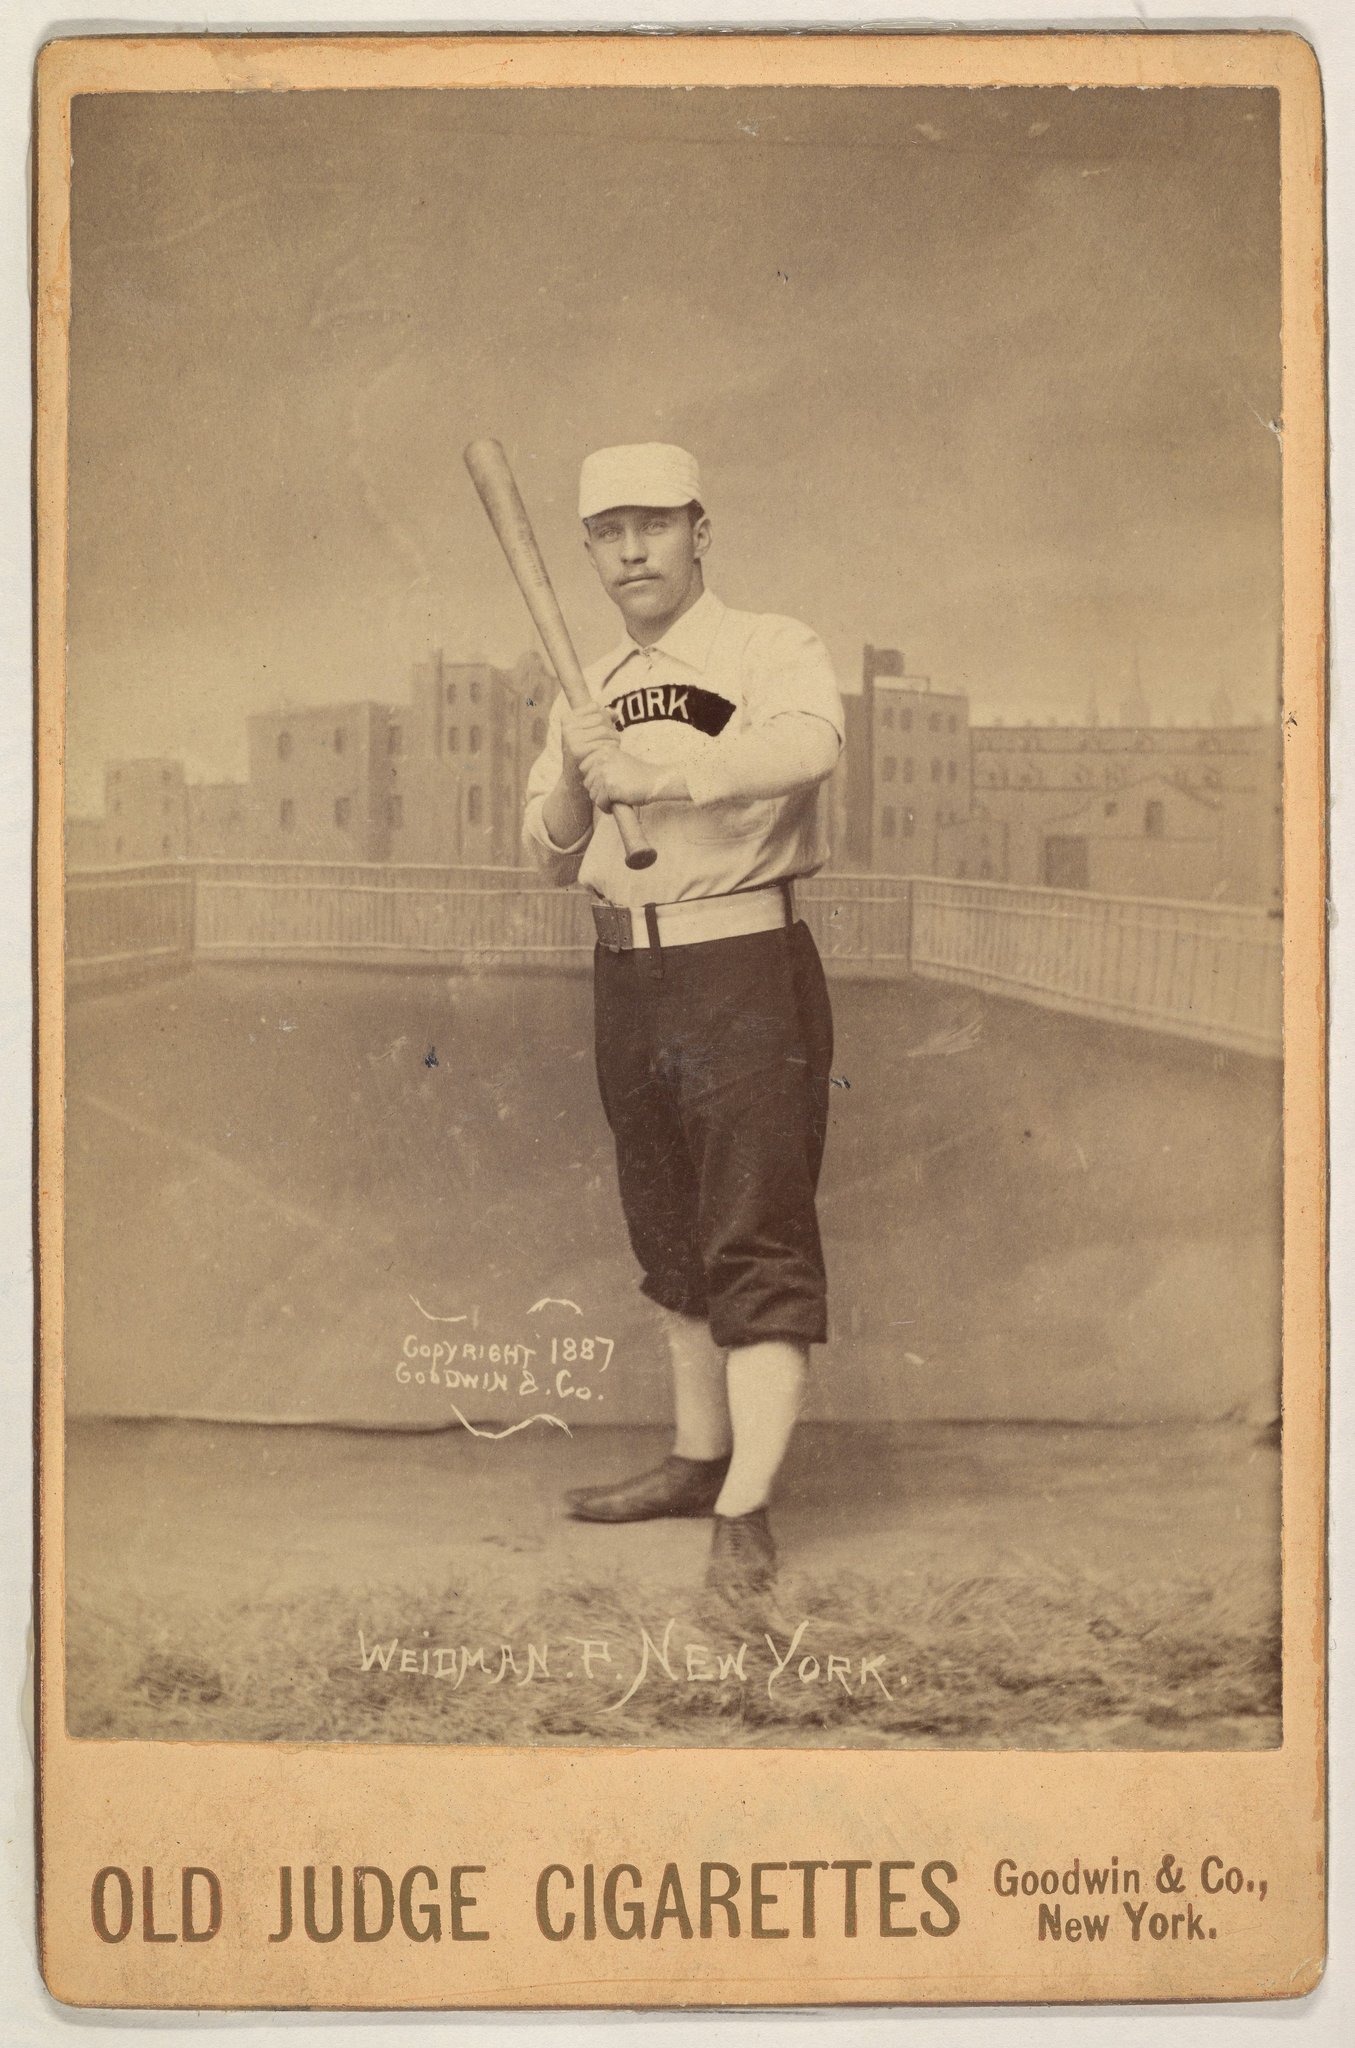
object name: baseball card, photograph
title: Weidman, Pitcher, New York, from the series Old Judge Cigarettes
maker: goodwin & company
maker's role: publisher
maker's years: 1850-1950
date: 1887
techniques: albumen silver print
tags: men,portraits,baseball,athletes